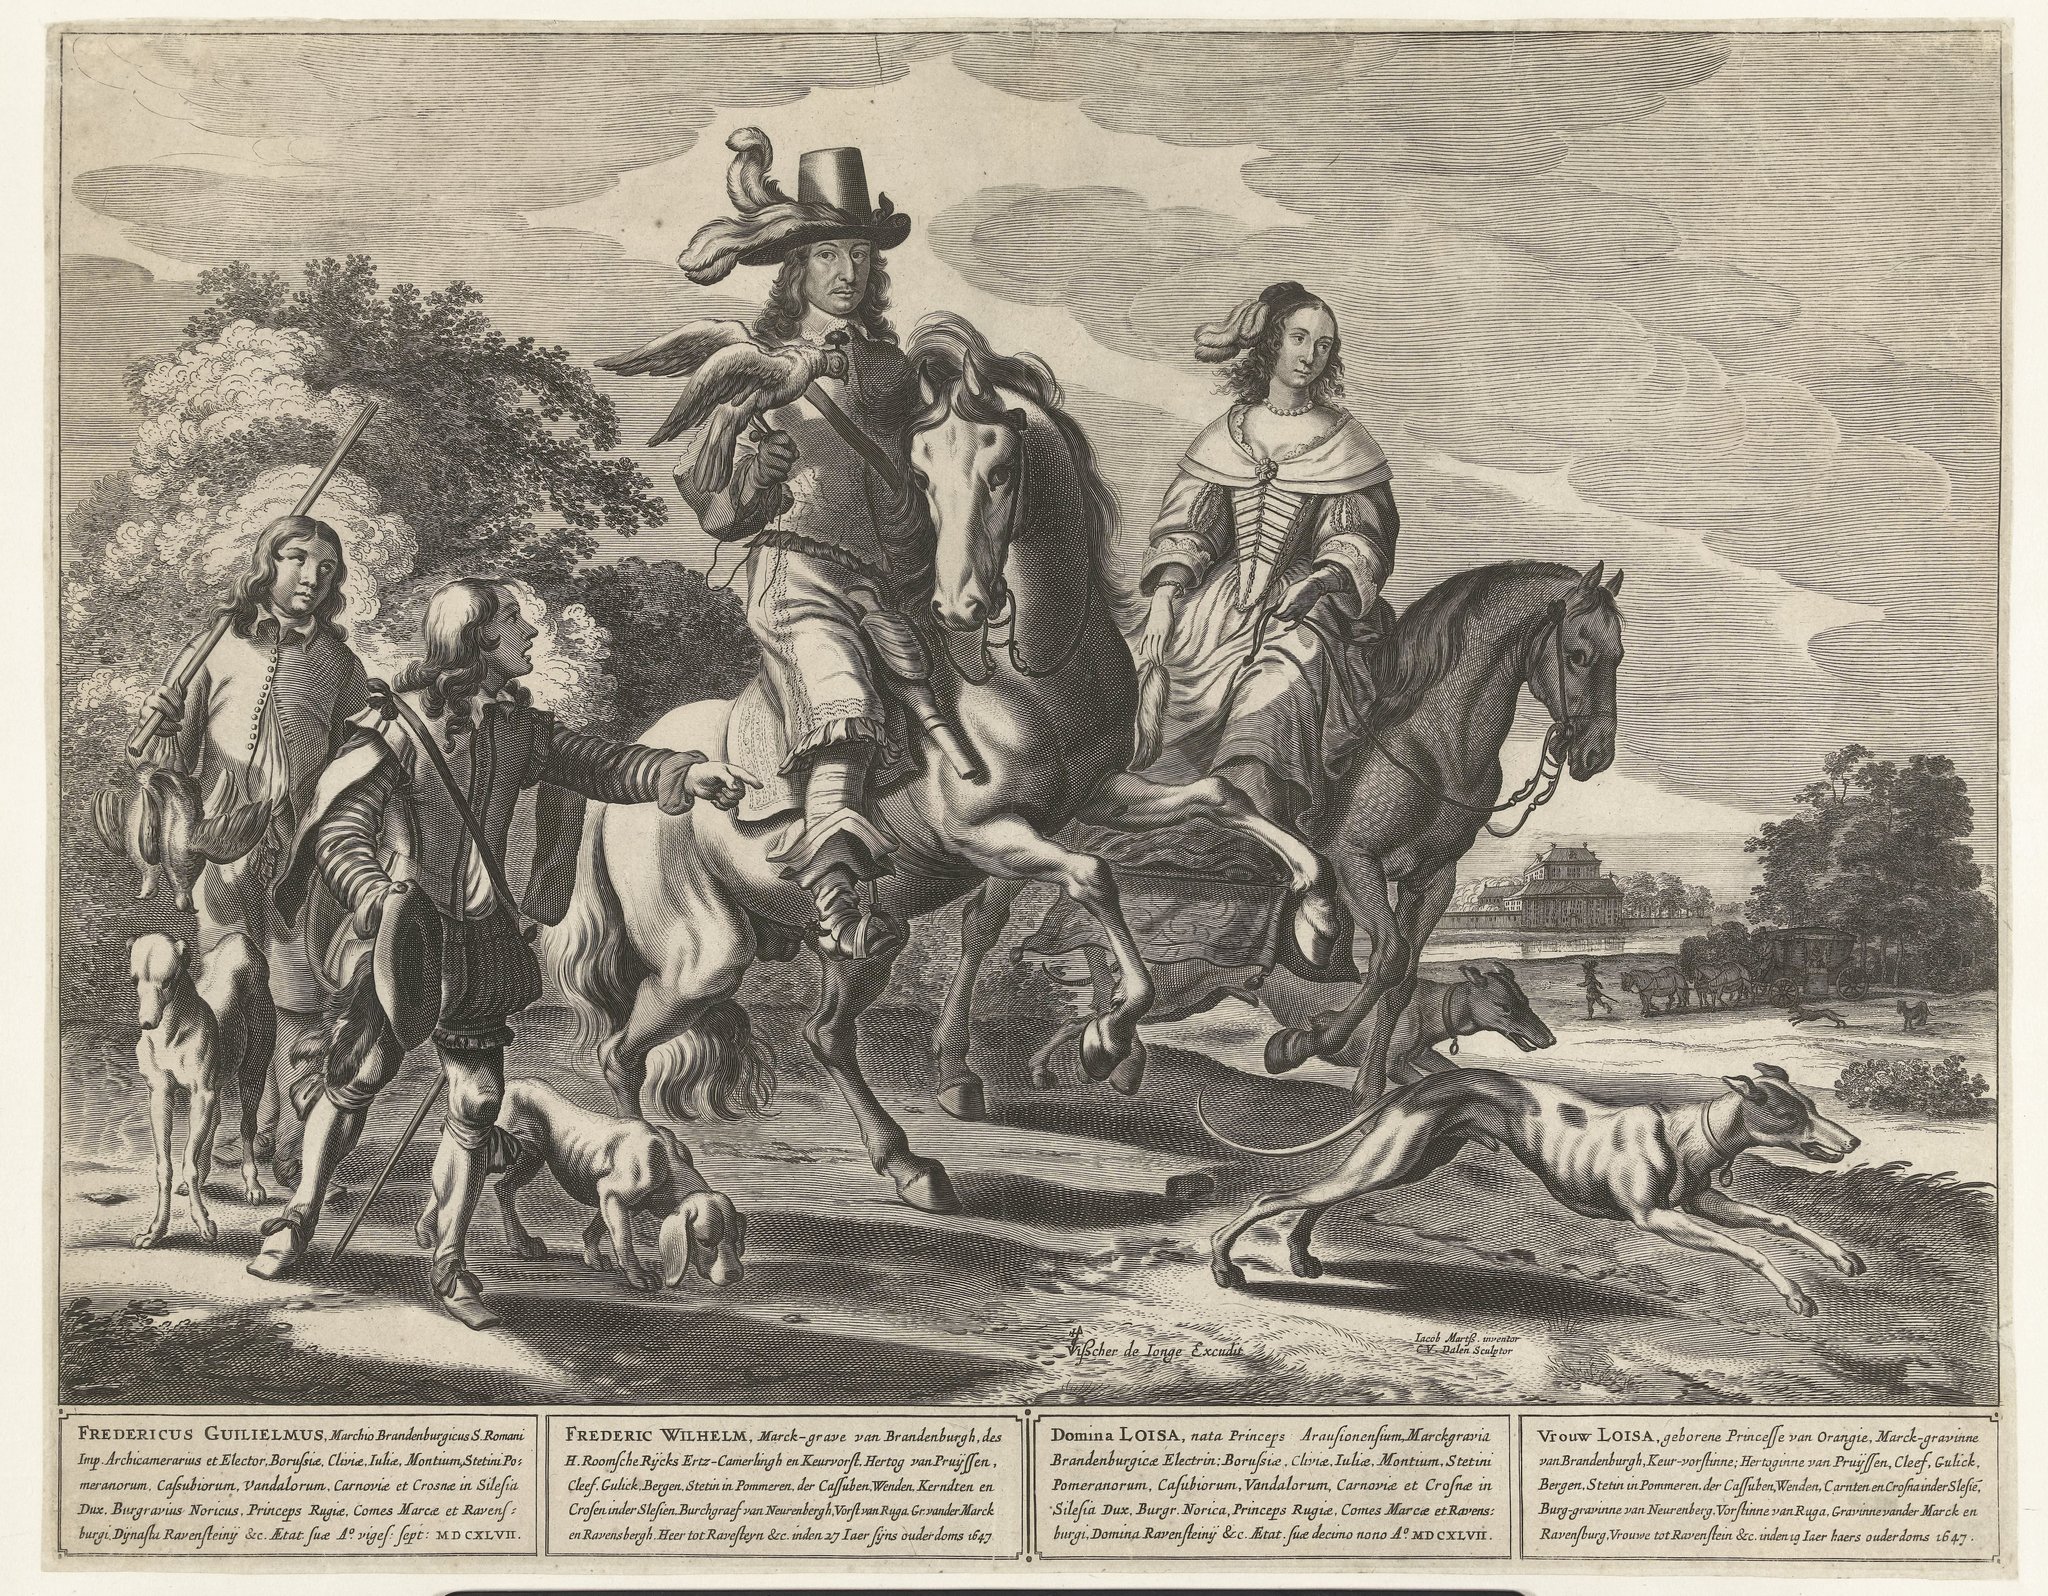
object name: print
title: Frederik Willem, keurvorst van Brandenburg en Louise Henriëtte, prinses van Oranje-Nassau tijdens valkenjacht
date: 1647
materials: paper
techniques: engraving, etching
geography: netherlands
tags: frederik willem van brandenburg (i), the hague, berlin, louise henriëtte (prinses van oranje), equestrian state-portrait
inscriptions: collector's mark: Lugt 2165, collector's mark: Lugt 963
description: Frederik Willem, keurvorst van Brandenburg op 27-jarige leeftijd en Louise Henriëtte, prinses van Oranje-Nassau op 19-jarige leeftijd, beiden te paard tijdens de valkenjacht in landschap met paleis. In de marge opschriften in Latijns en Duits met namen en titels van beide geportretteerden.